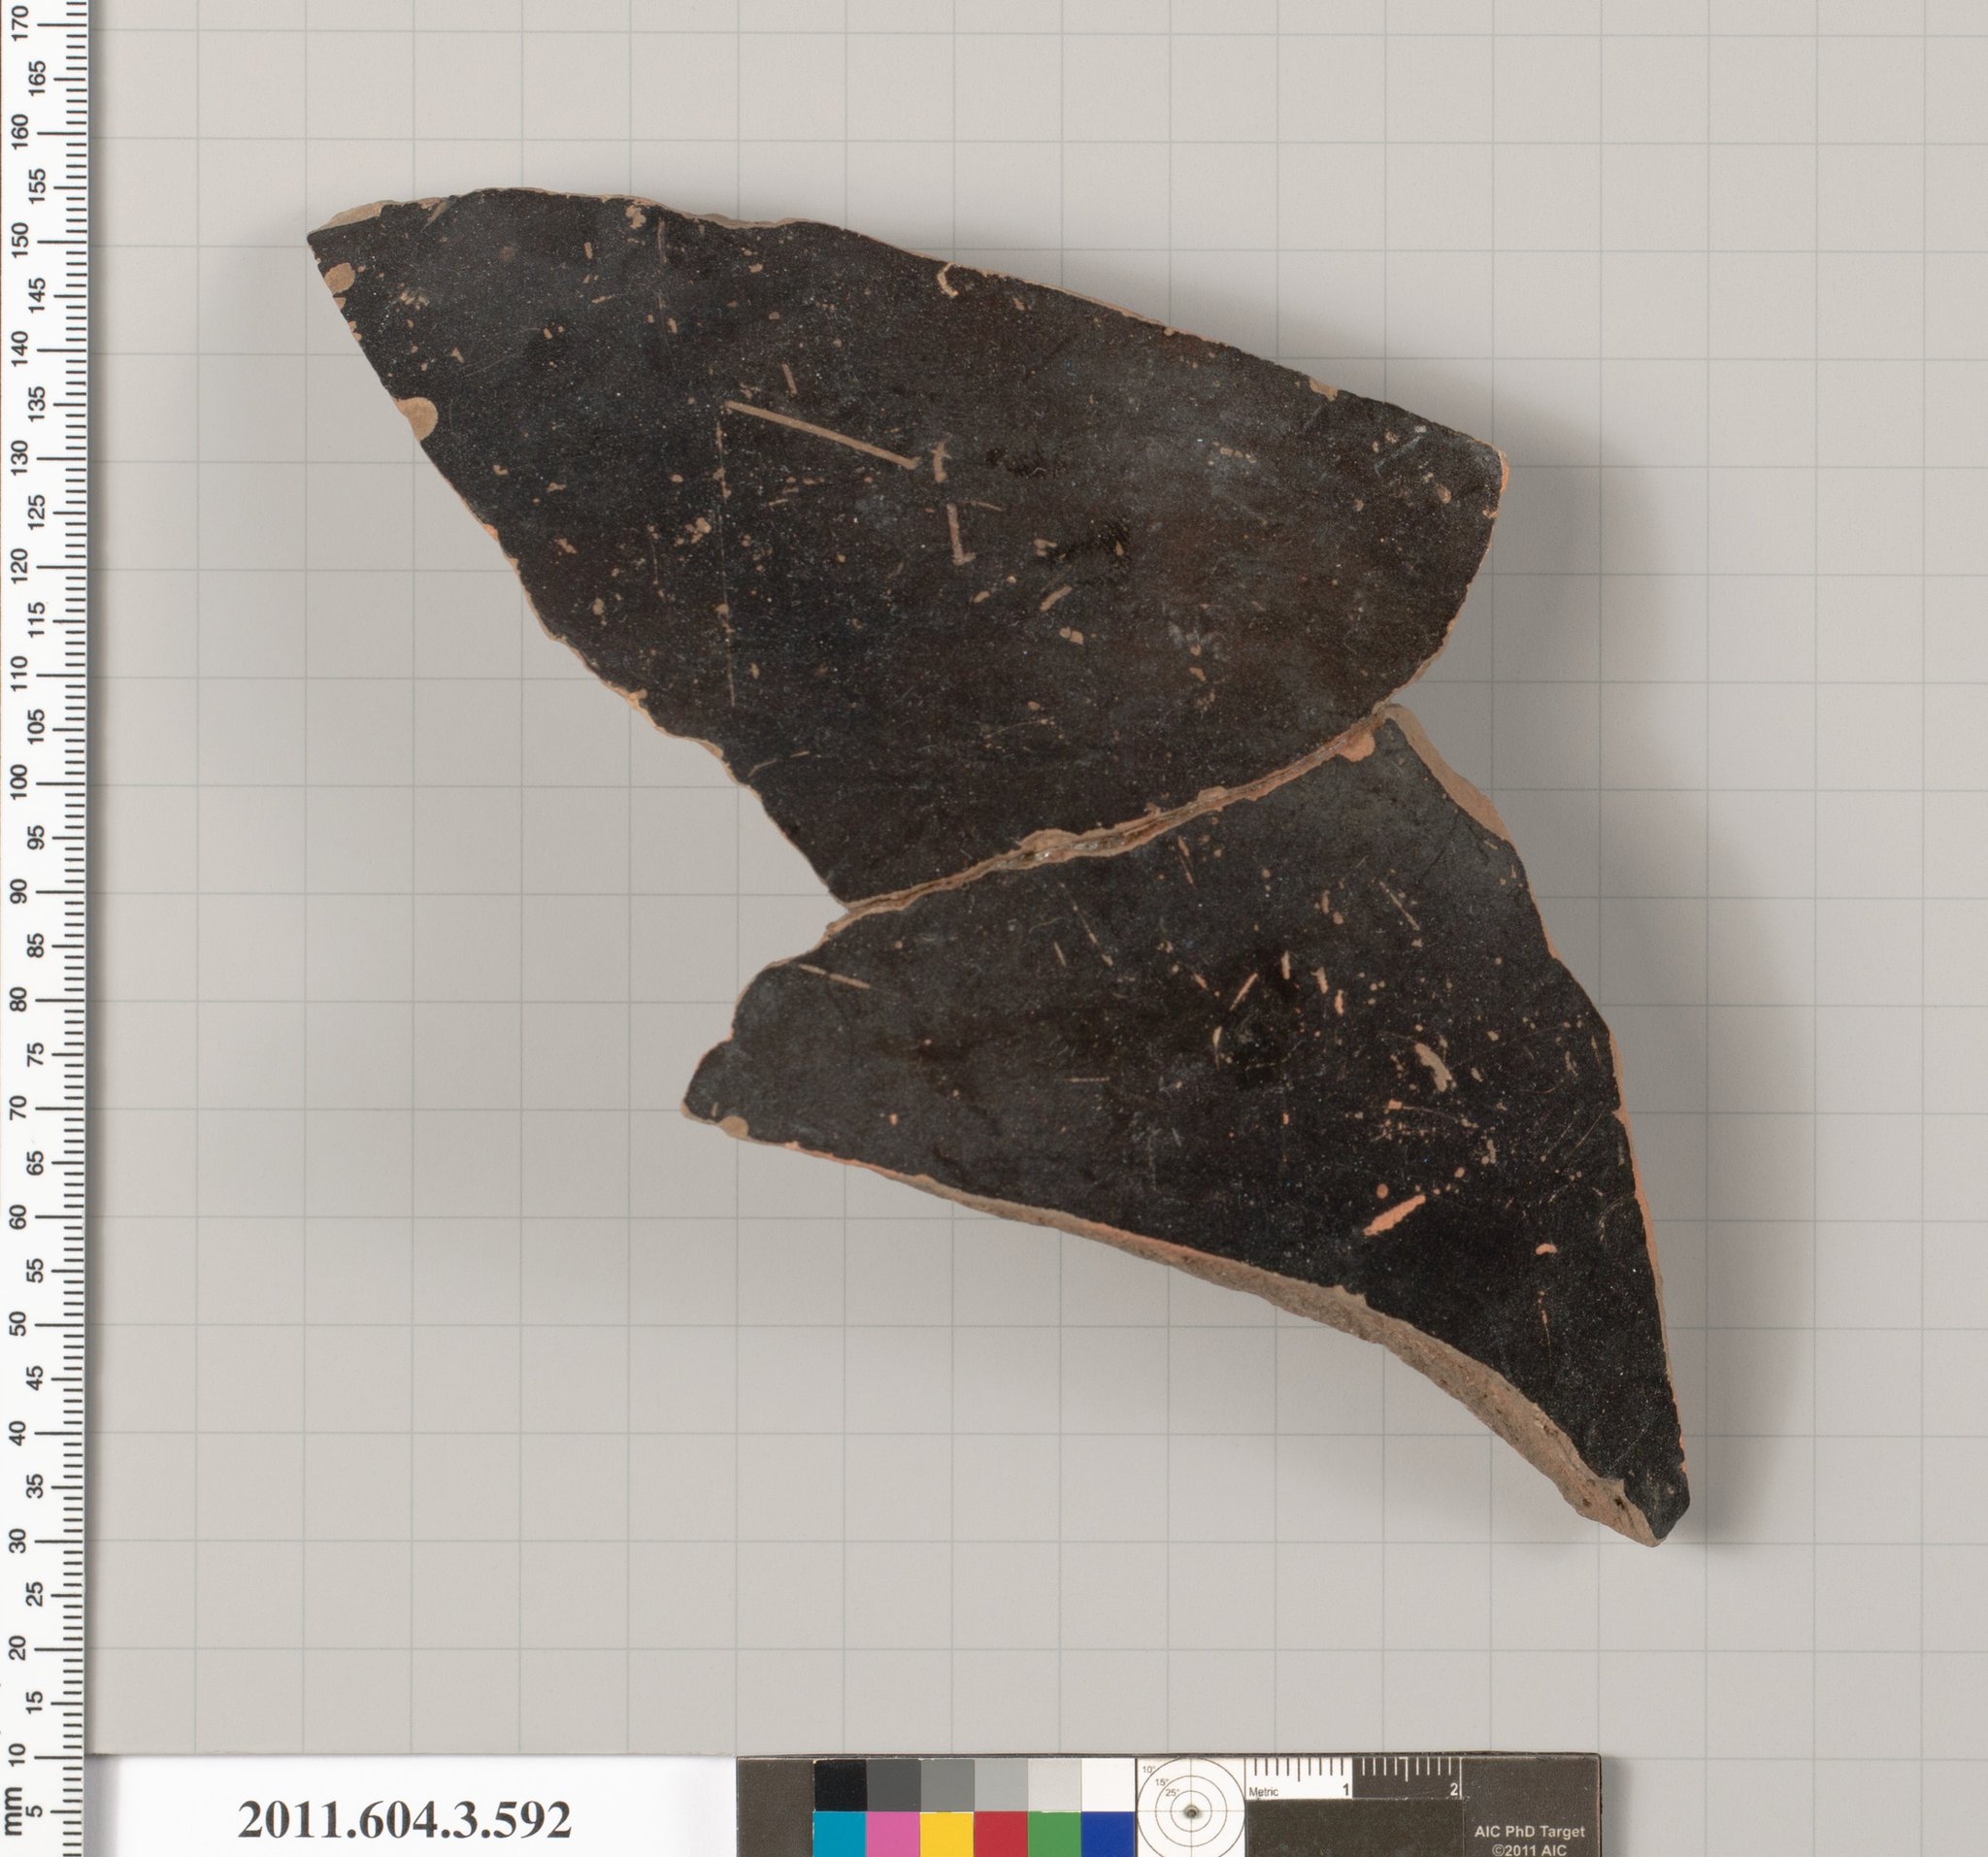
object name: column krater fragment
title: Terracotta fragment of a column-krater (bowl for mixing wine and water)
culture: greek, attic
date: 600-401 BCE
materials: terracotta